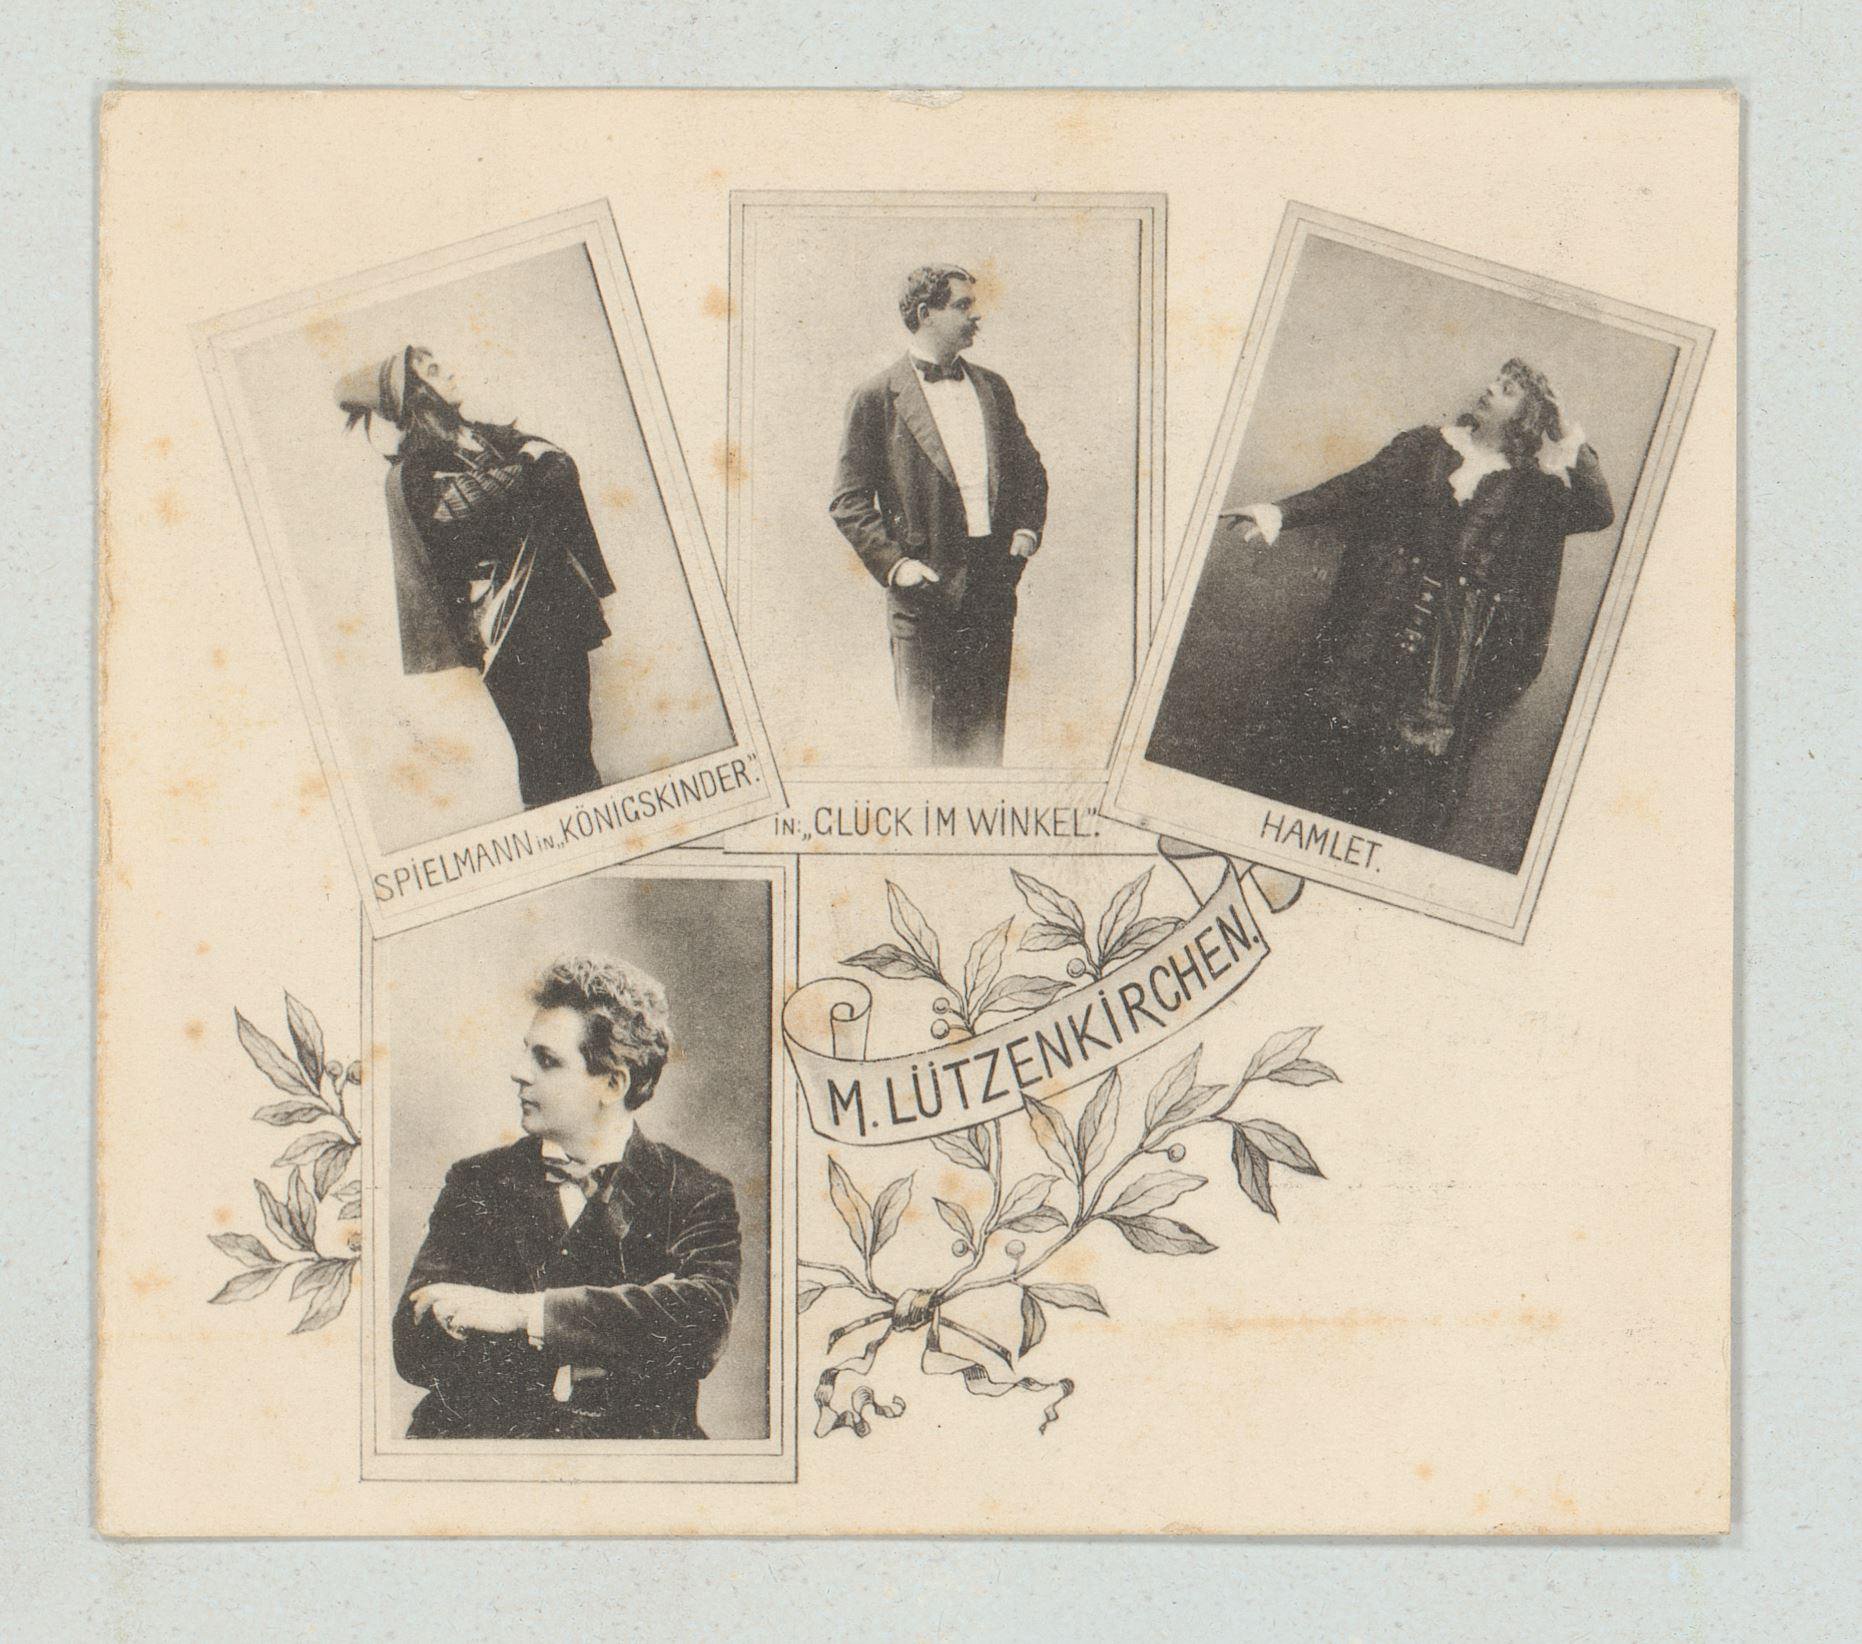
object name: ansichtkaart, prentbriefkaart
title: Vier portretten van acteur M. Lüzenkirchen in verschillende rollen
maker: Anonymous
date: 1890-1930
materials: cardboard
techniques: photograph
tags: historical persons, portrait of actor, actress